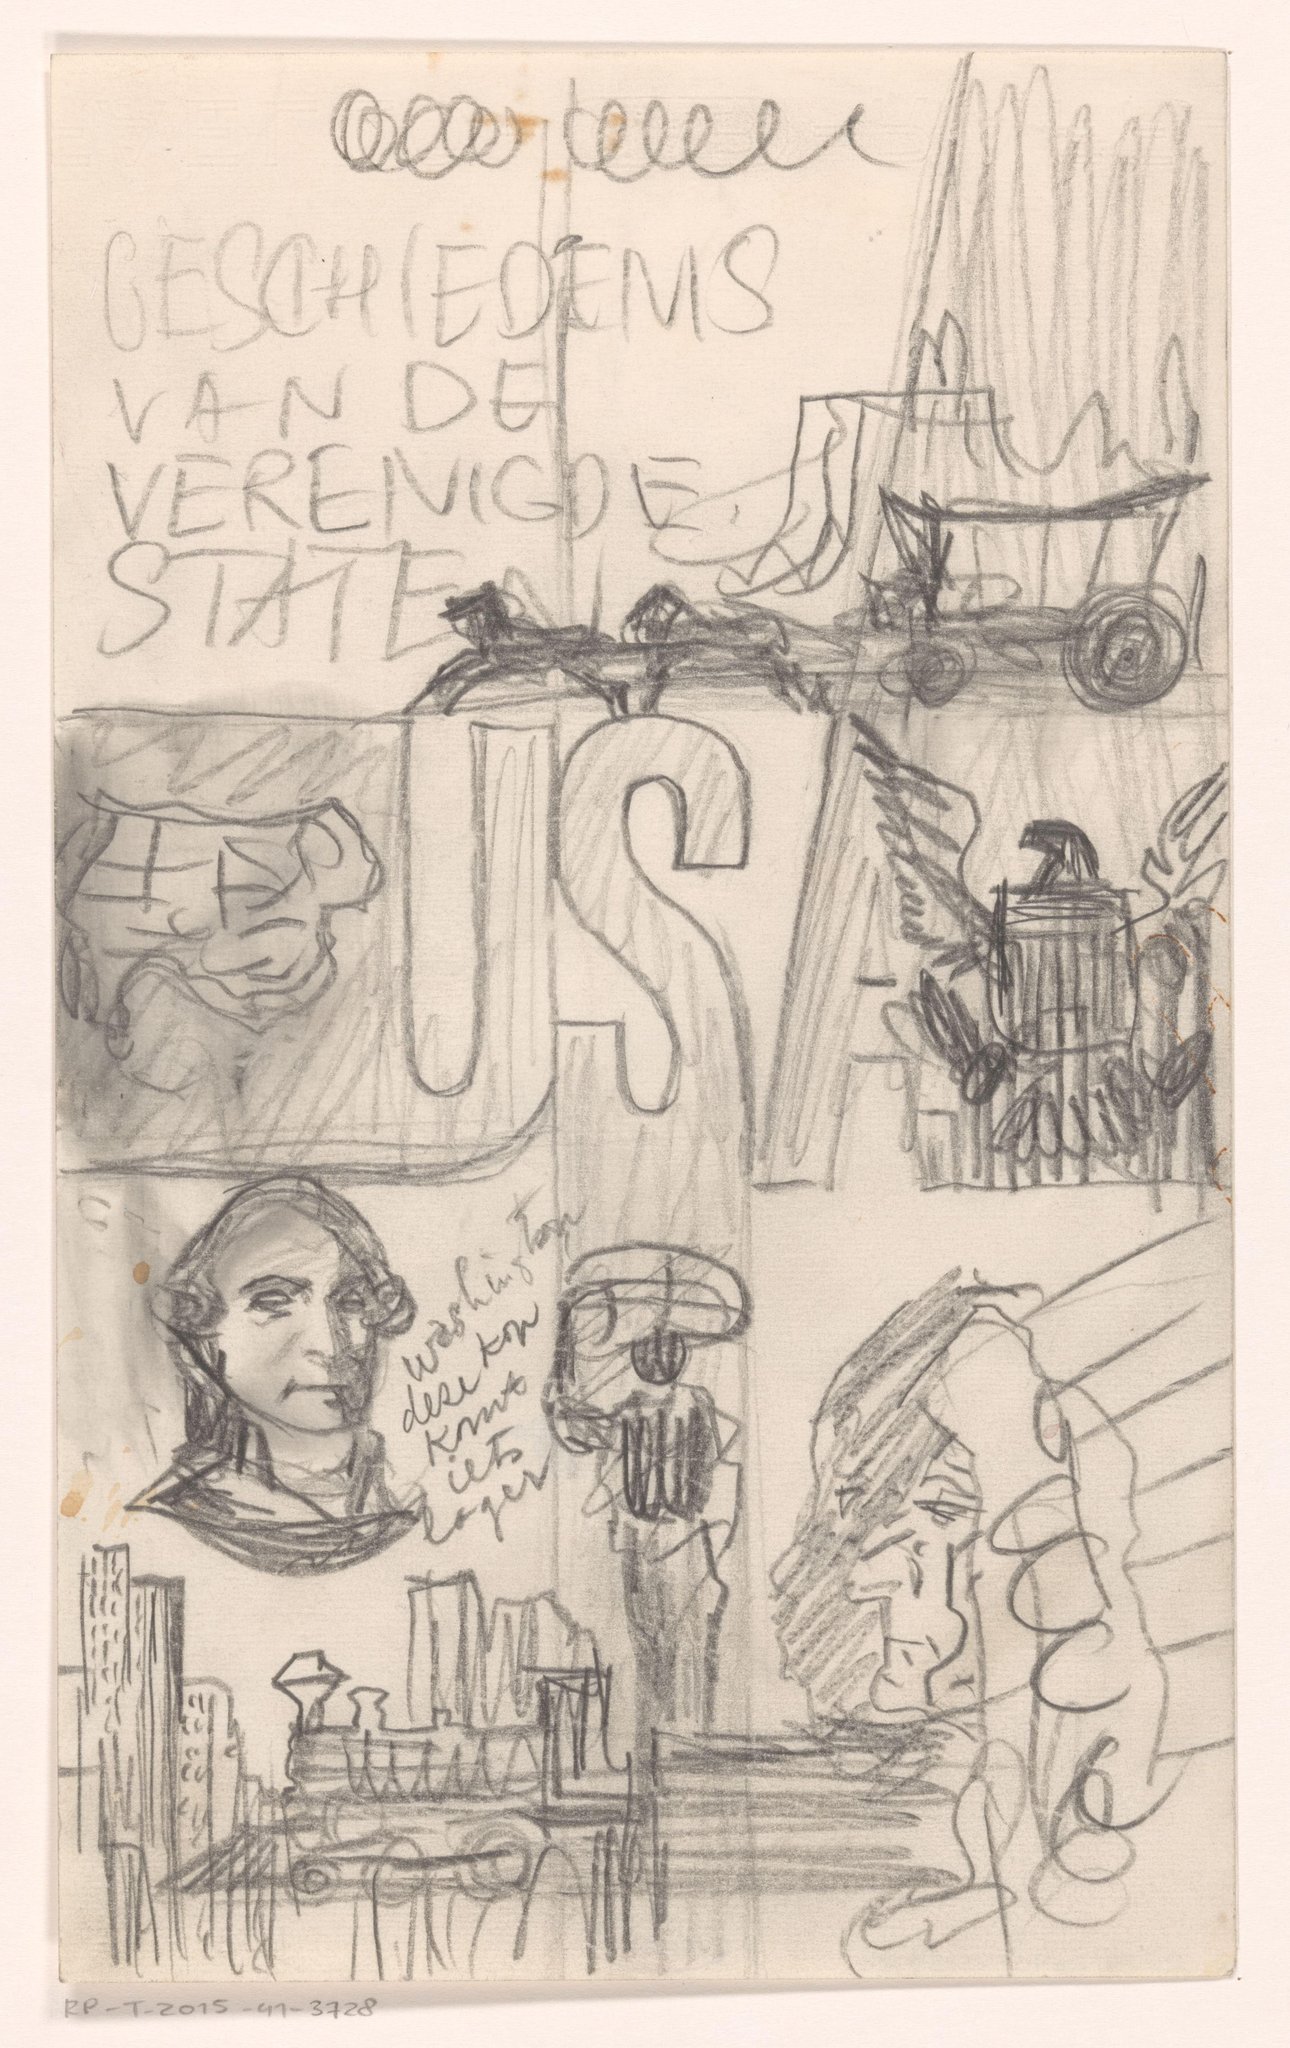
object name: drawing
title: Bandontwerp voor: André Maurois, Geschiedenis van de Verenigde Staten, 1964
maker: Anonymous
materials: paper, pencil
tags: skyscraper, maps of separate countries or regions, historical persons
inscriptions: annotation: ‘washington/ deze kop/ komt/ iets/ lager’, collector's mark: Lugt 2228a, :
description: Bandontwerp met een samenstelling van voorstellingen, waaronder een kaart van de Verenigde Staten, de letters 'USA', een stadsgezicht met wolkenkrabbers, een portret van George Washington en een arend met de vlag van de Verenigde Staten.